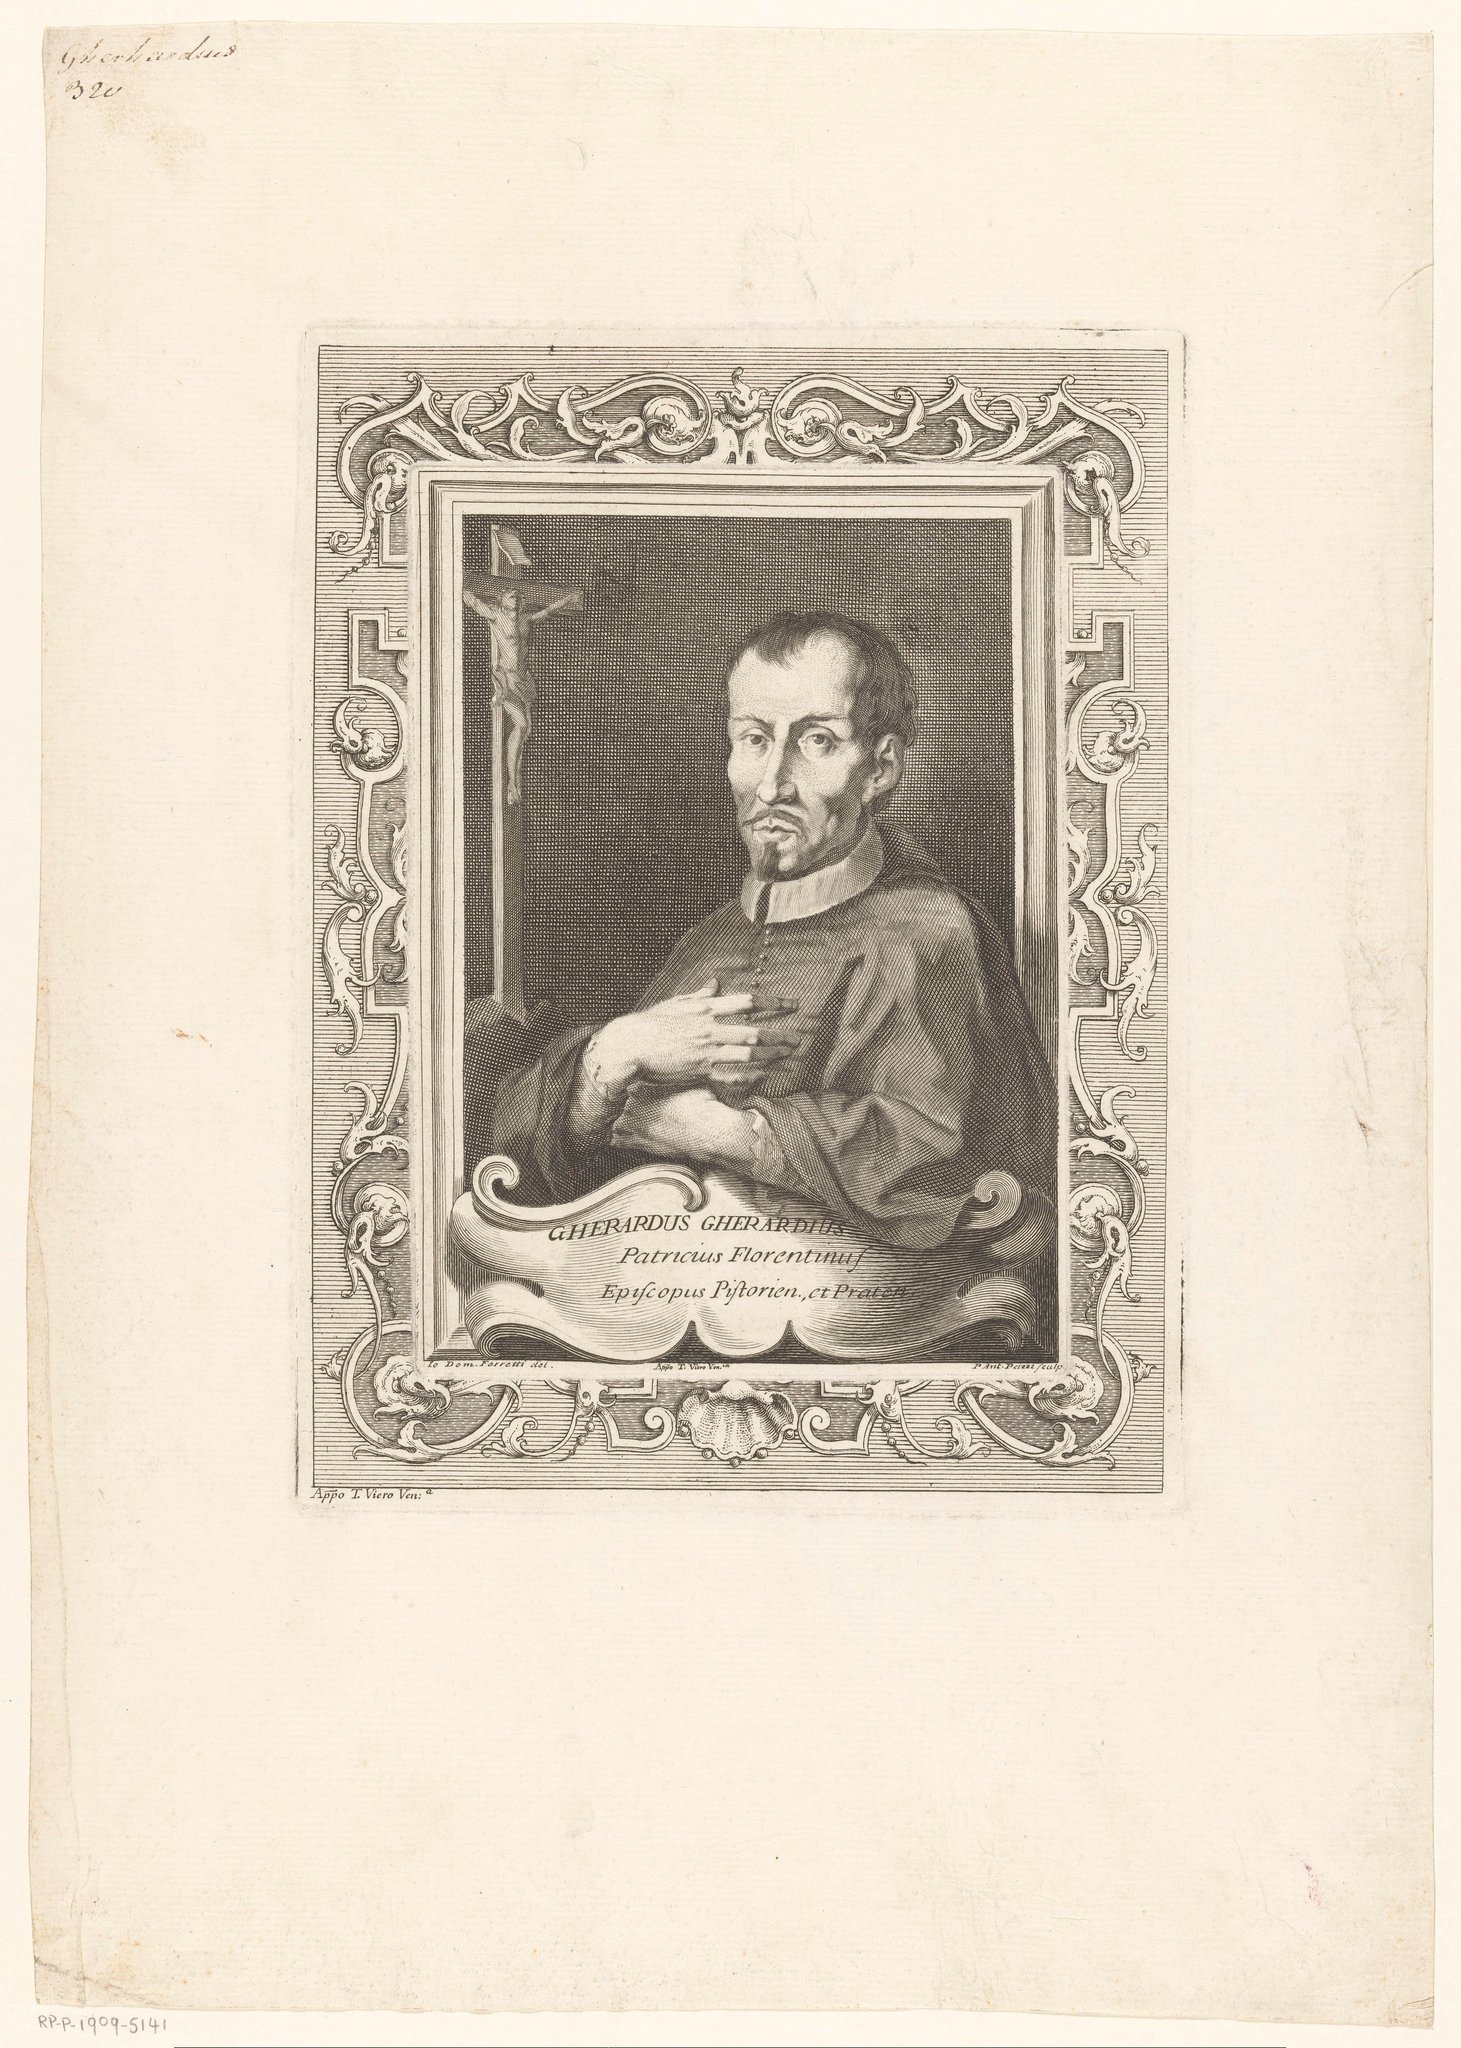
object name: print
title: Portret van bisschop Gherardo Gherardi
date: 1750-1819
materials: paper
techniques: engraving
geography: venice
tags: archbishop, bishop, etc. (roman catholic), historical persons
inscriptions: collector's mark: Lugt 2228, inscription: ‘Gherhardus’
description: Deze prent maakt deel uit van een serie van onbekende omvang, met portretten van bisschoppen en kardinalen in ornamentlijsten.